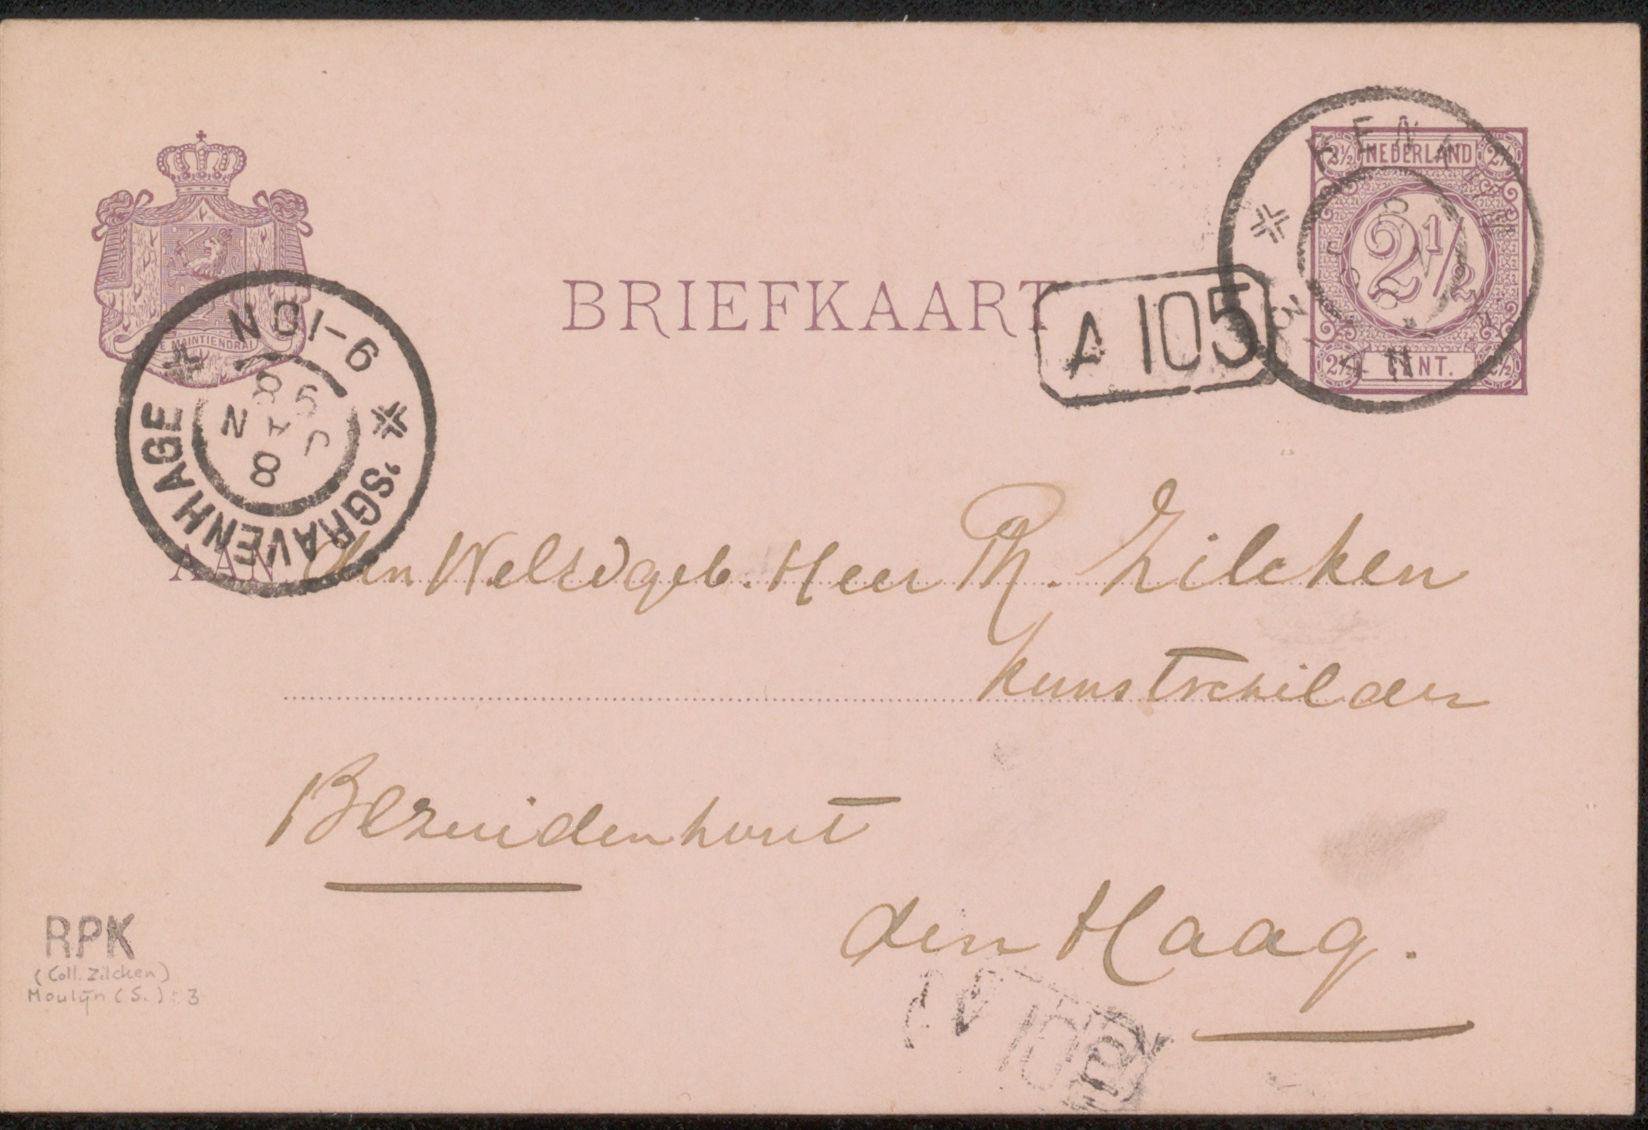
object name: postcard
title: Briefkaart aan Philip Zilcken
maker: simon moulijn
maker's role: draughtsman, print maker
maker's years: 1866-1948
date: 1898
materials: cardboard, ink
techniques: pen, writing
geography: renkum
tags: painter, philip zilcken, the graphic arts, exhibition ~ art, venice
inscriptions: collector's mark: ‘RPK’